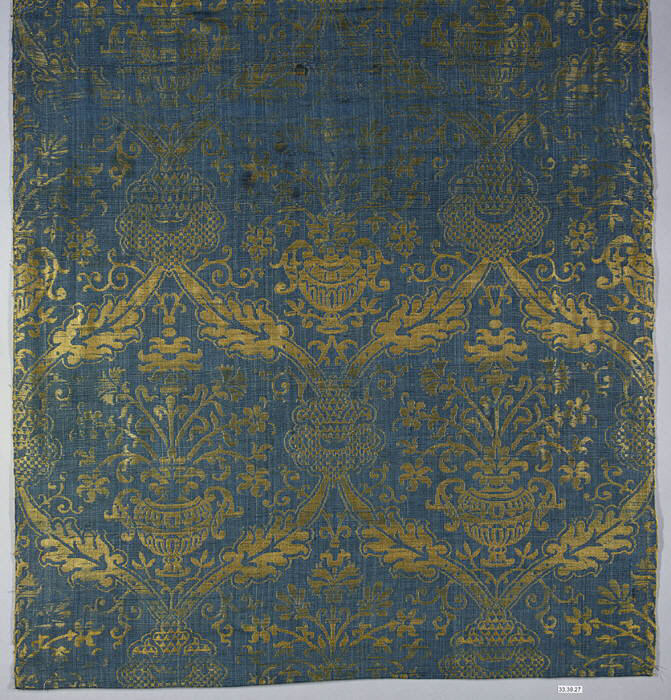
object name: fragment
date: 1501-1550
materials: silk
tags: flowers,leaves